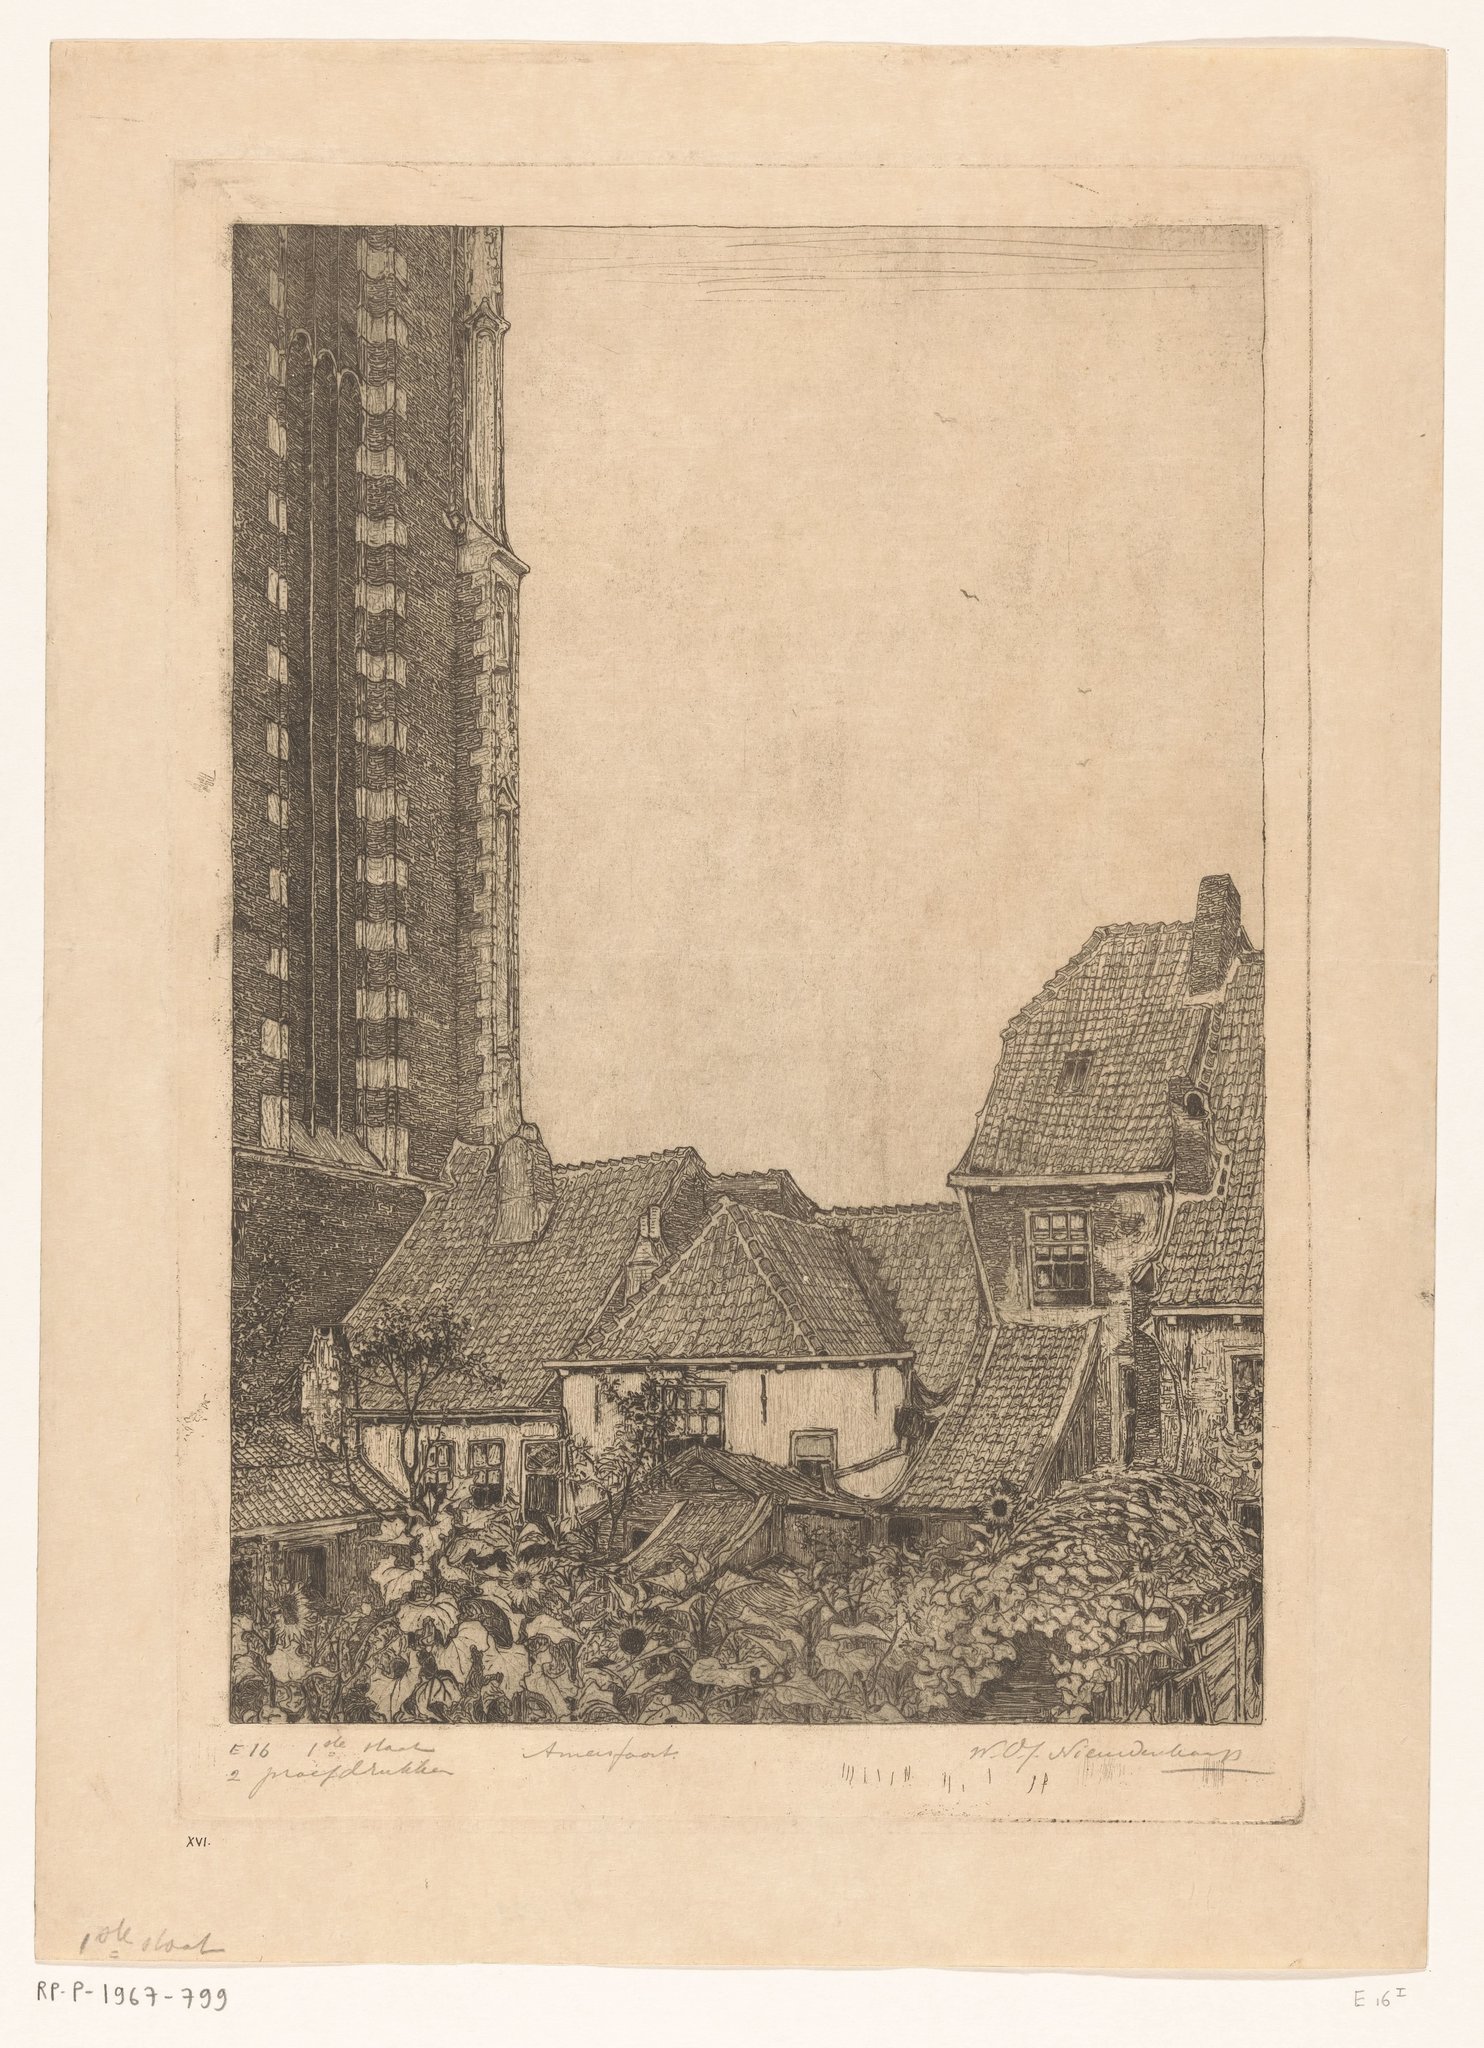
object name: print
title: Huizen bij de Onze-Lieve-Vrouwetoren in Amersfoort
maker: wijnand otto jan nieuwenkamp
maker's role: draughtsman, print maker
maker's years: 1874-1950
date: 1896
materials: paper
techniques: intaglio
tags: urban housing, flowers: sunflower, parts of church exterior and annexes: tower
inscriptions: collector's mark: Lugt 2228, collector's mark: Lugt 2760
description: Op de voorgrond zonnebloemen en andere planten in de achtertuinen van de huizen.